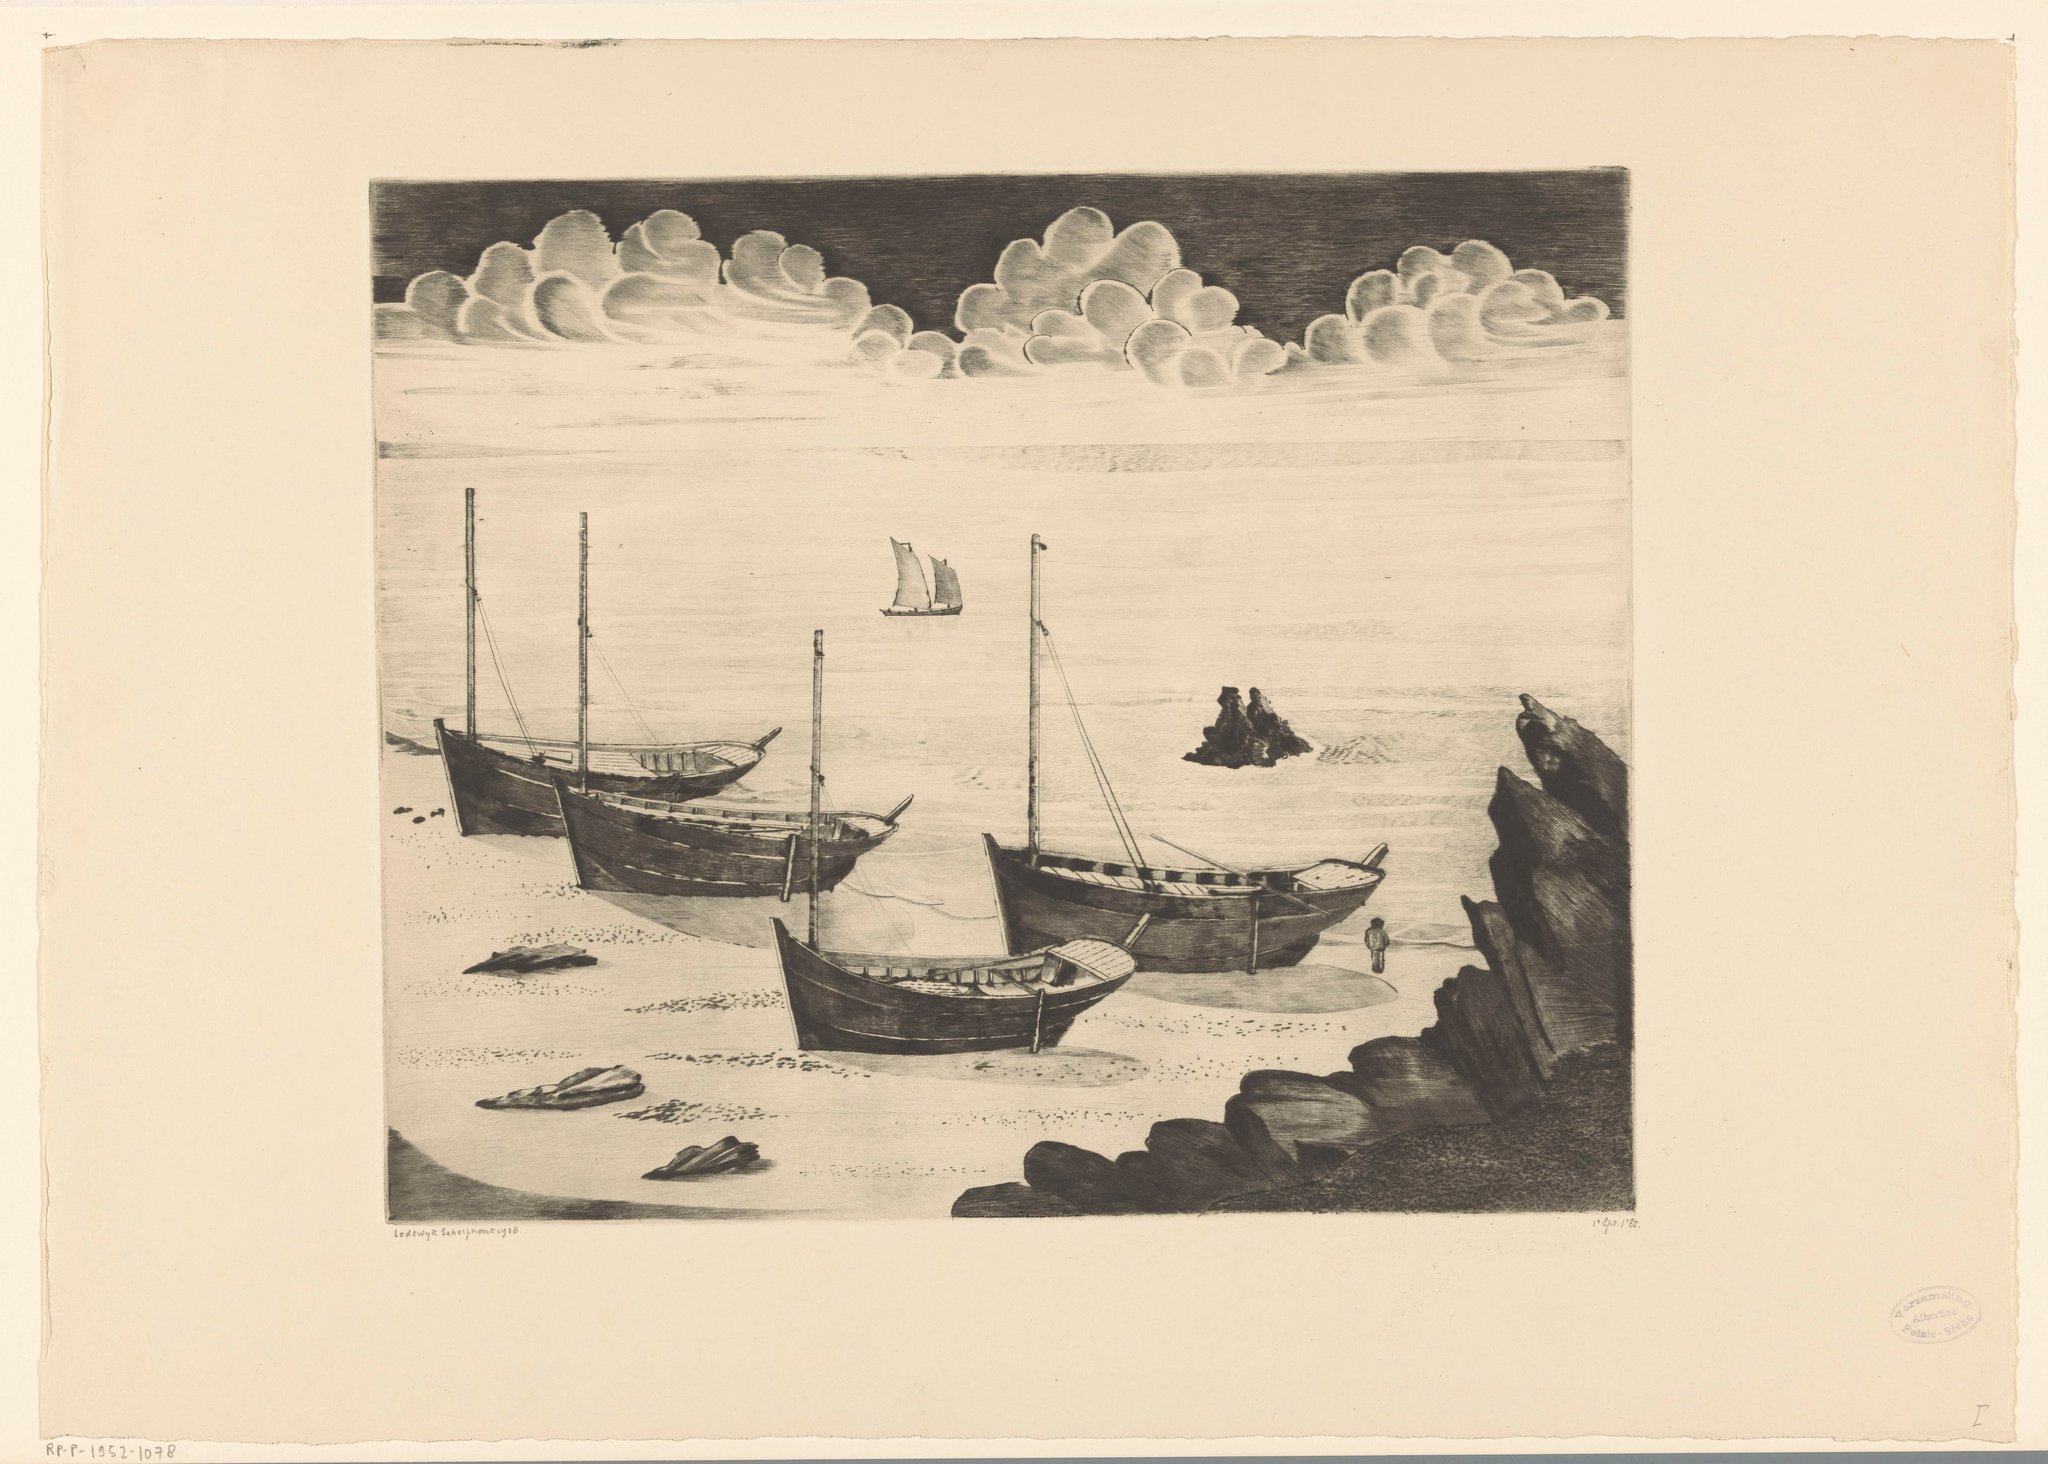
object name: print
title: Après l'orage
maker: lodewijk schelfhout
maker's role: draughtsman, print maker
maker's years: 1881-1943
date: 1928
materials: paper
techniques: drypoint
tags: clouds, rocky coast, ships (in general)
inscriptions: collector's mark: Lugt 5i, collector's mark: Lugt 2228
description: Een menselijke figuur bij vier afgemeerde schepen op een strand. Rechts op de voorgrond rotsen. Op zee een zeilschip. Aan de hemel wolken.